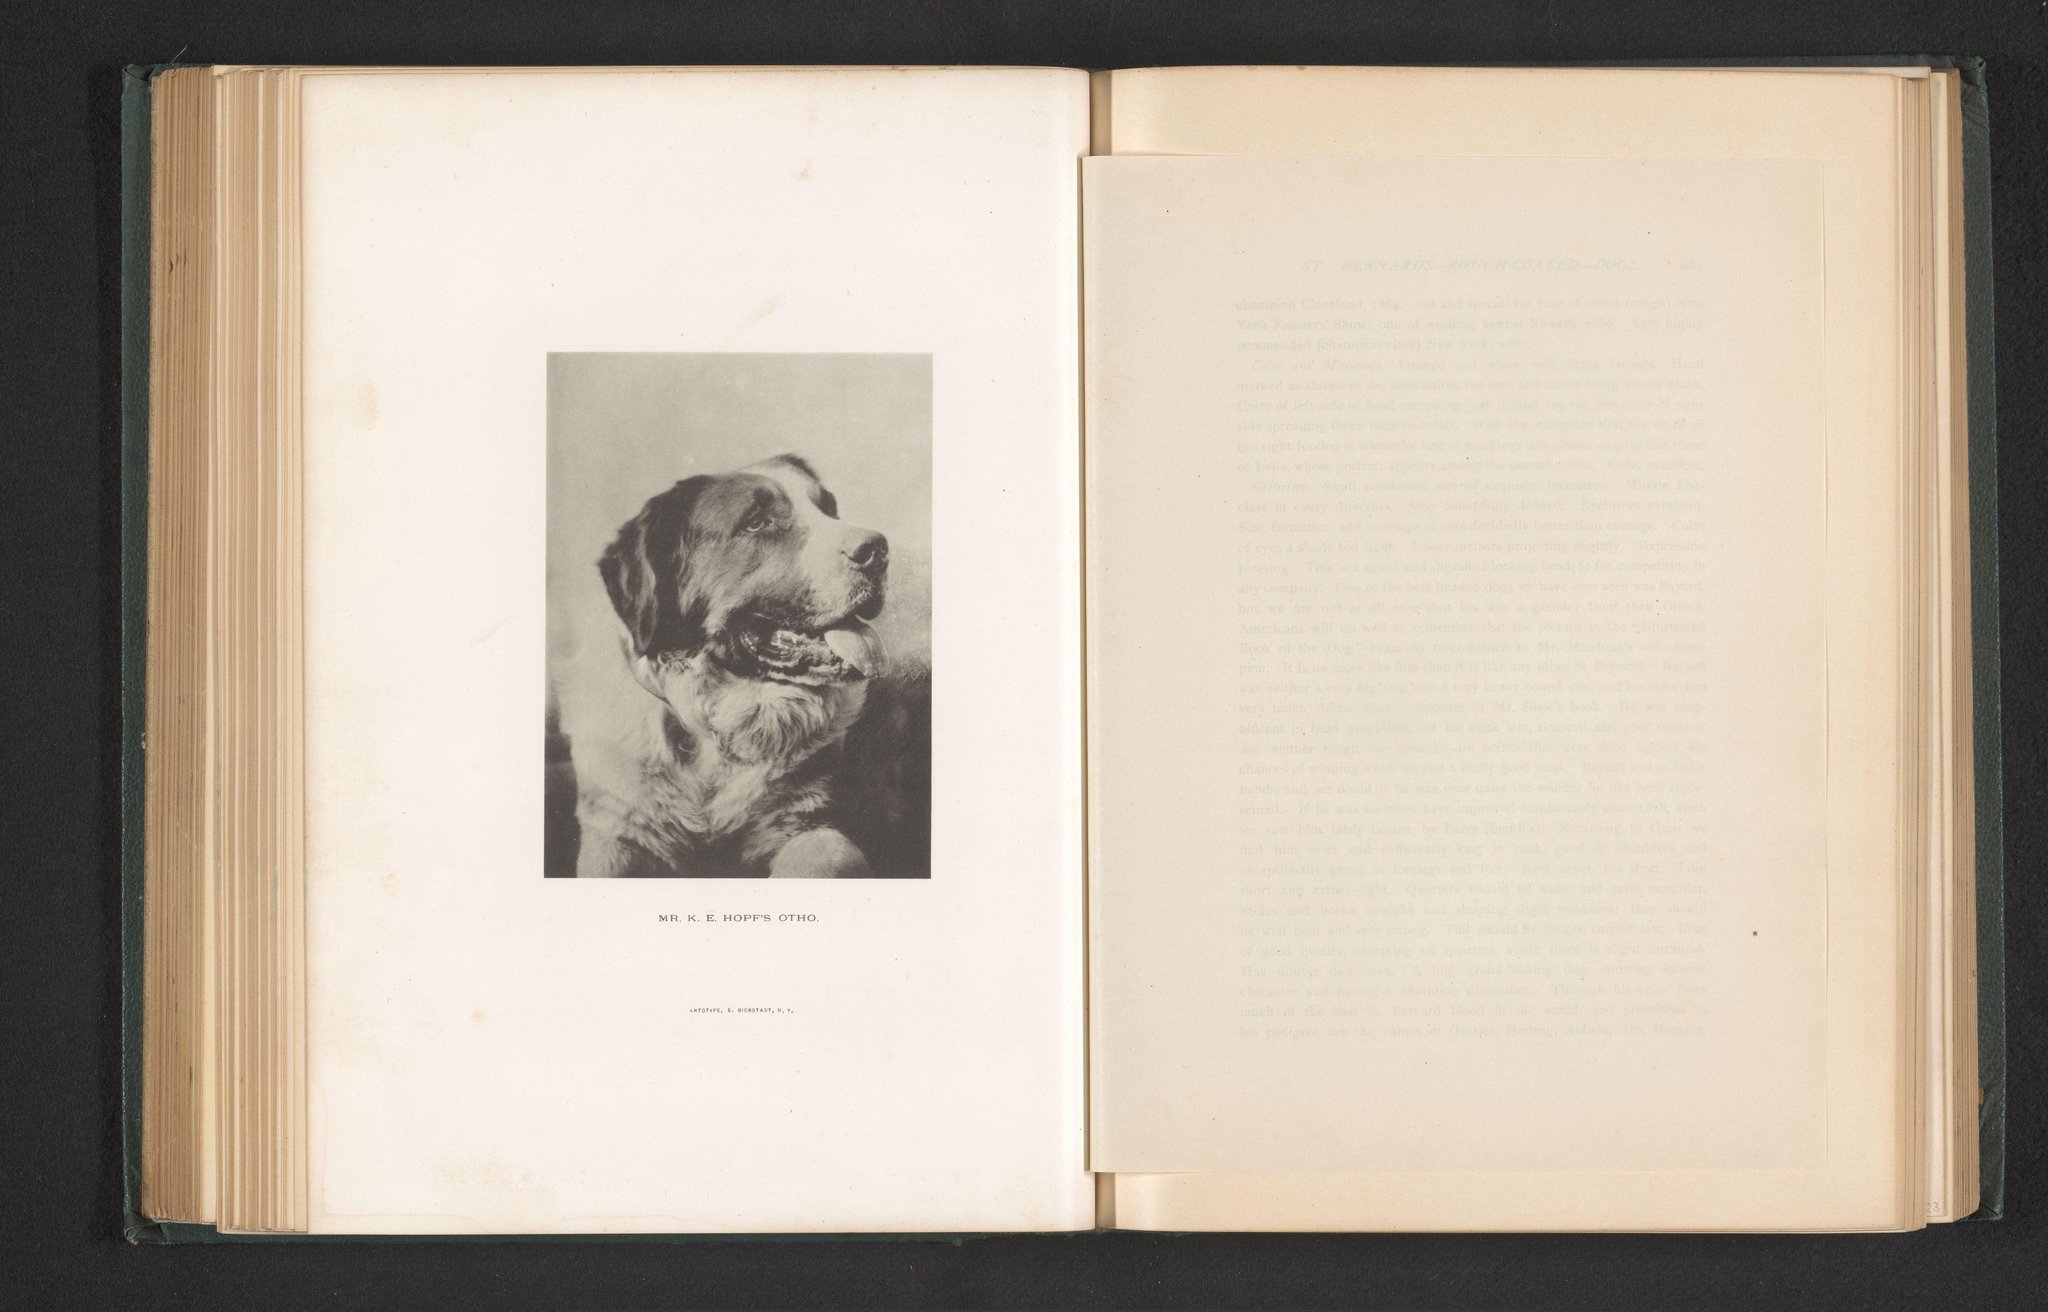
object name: photomechanical print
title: Sint-bernard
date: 1883-1888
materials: paper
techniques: photograph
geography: new york city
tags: dog (st.bernard)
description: Prent tegenover pagina 287, achter semi-transparante omslag.